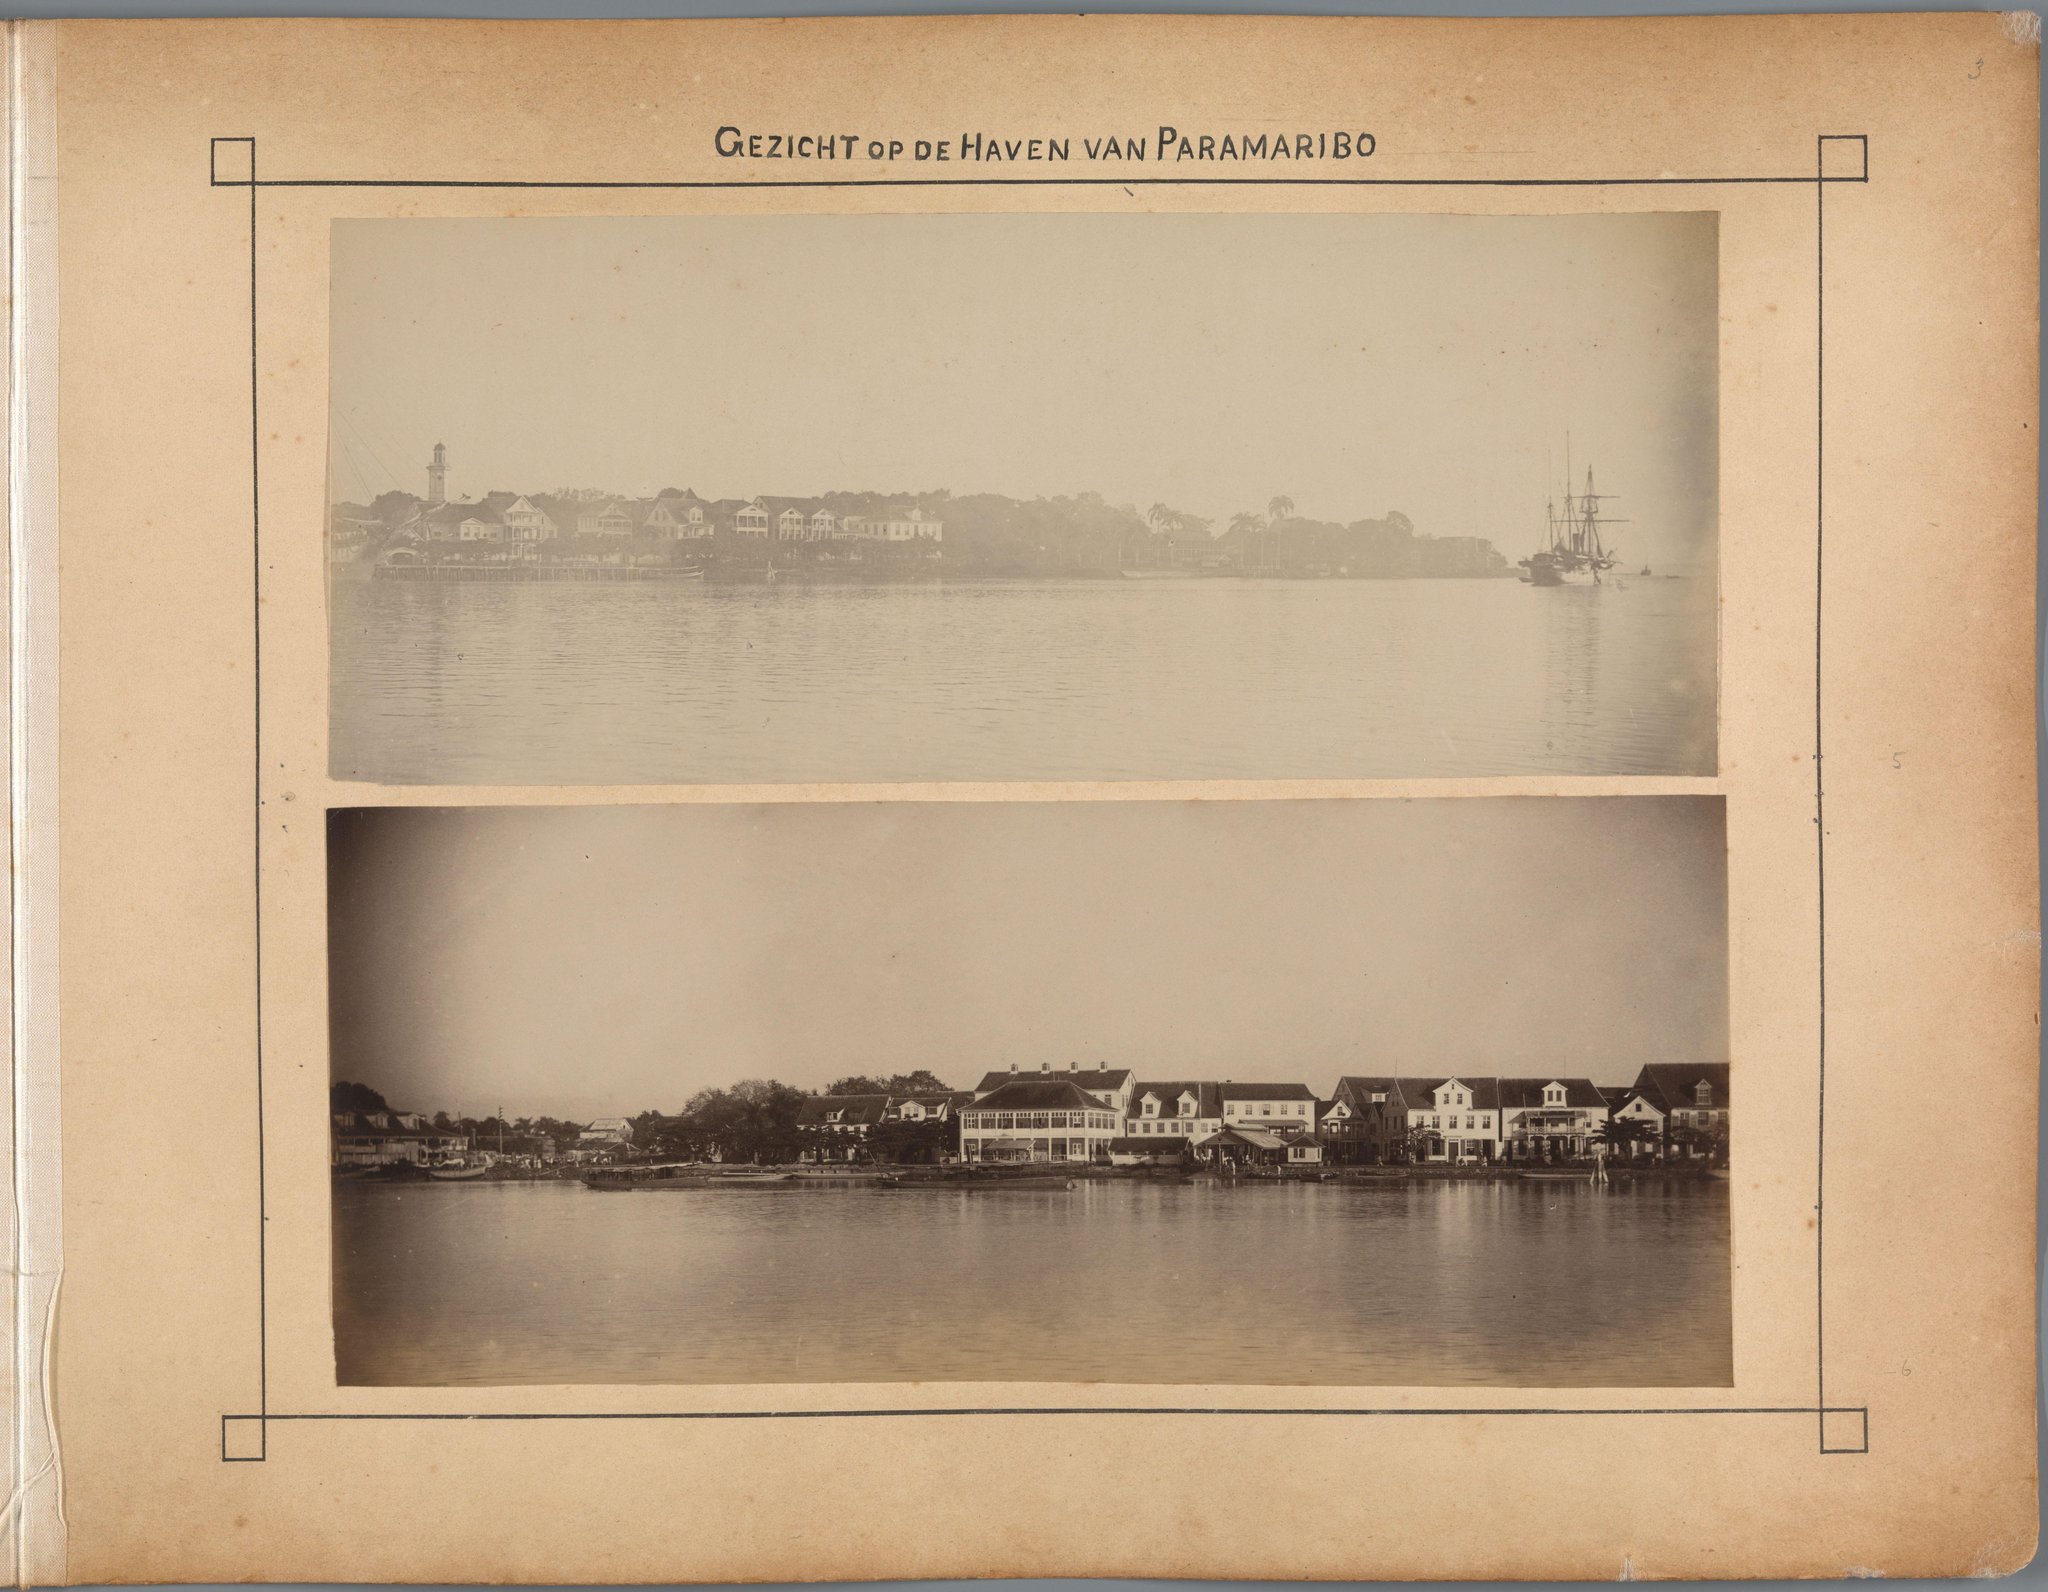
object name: photograph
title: Gezicht op haven van Paramaribo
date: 1898-1902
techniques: gelatin silver print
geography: suriname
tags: suriname